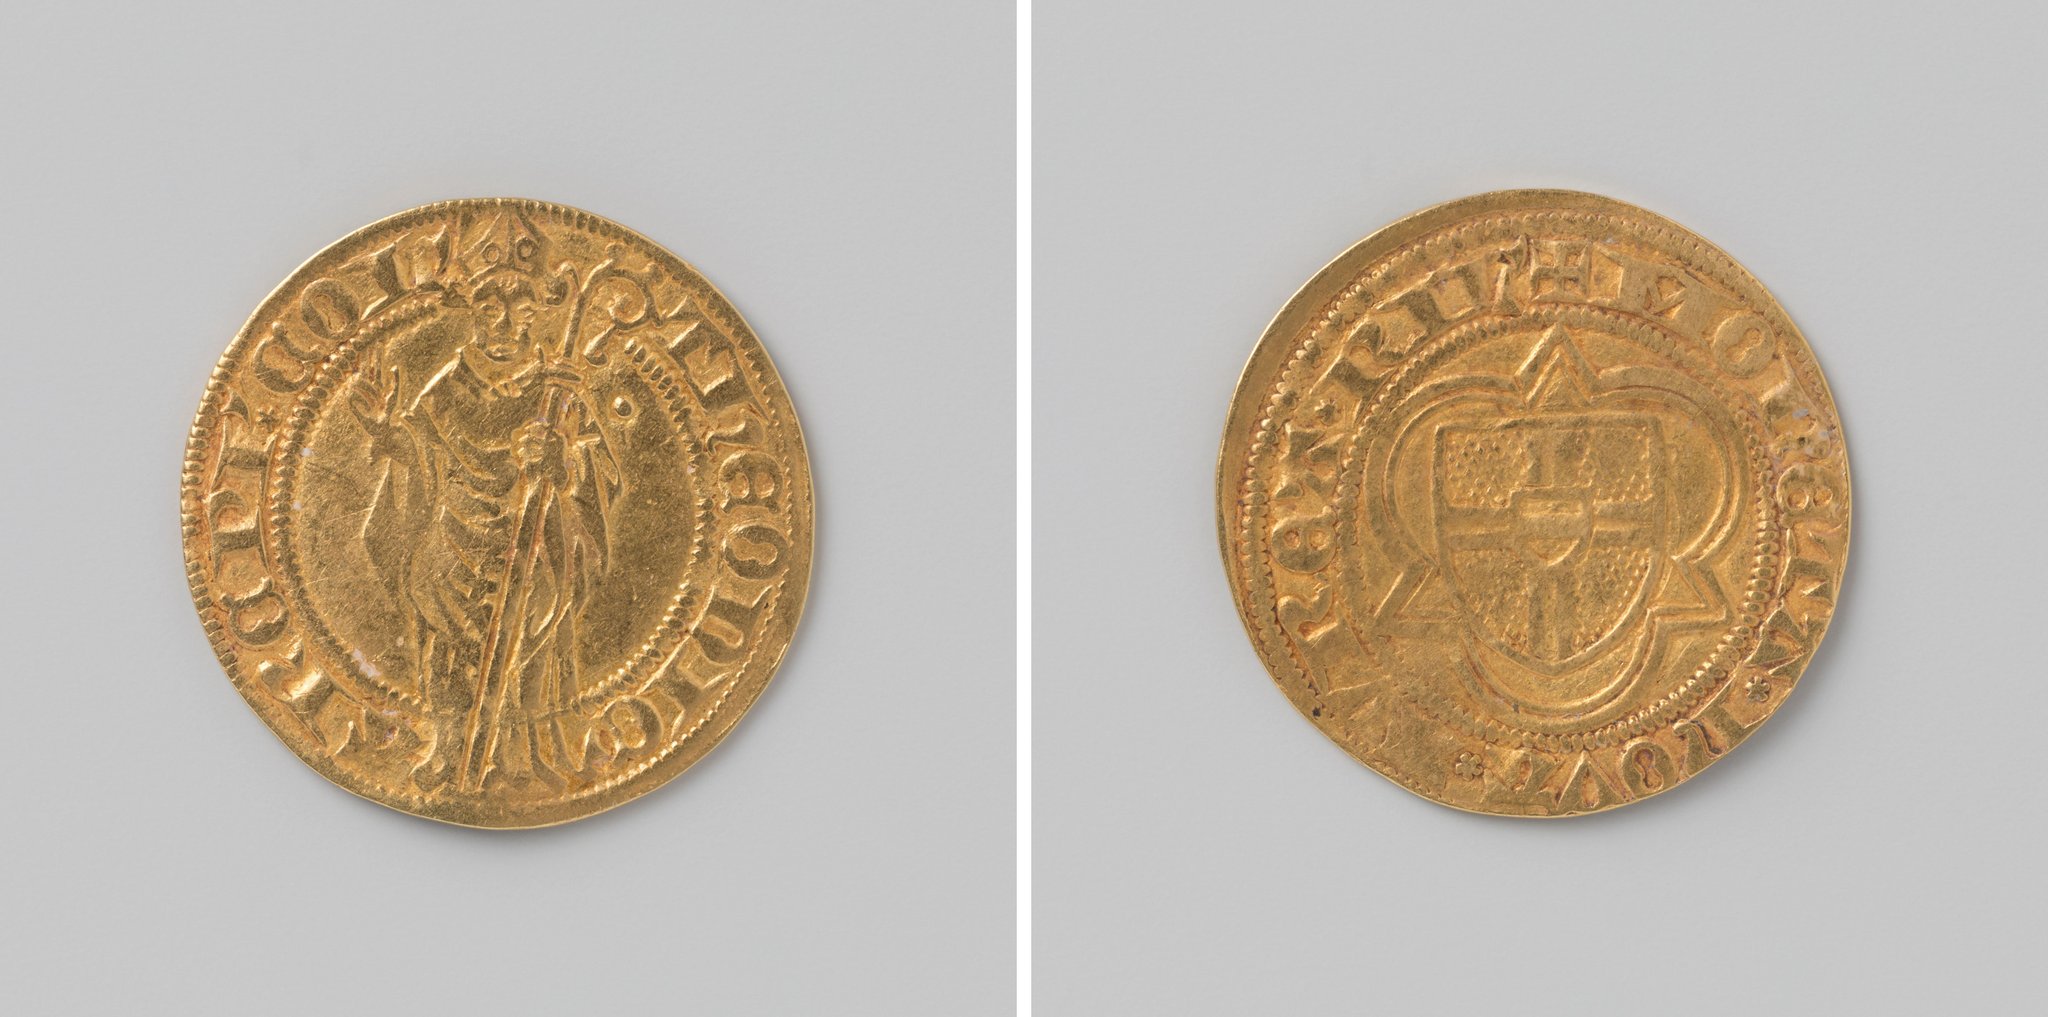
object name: coin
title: Rijnsgulden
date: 1430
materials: gold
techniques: striking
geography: riel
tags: germany, brielle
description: Opgegraven in de tuin van het in 1557 gestichte Merula-weeshuis te Brielle.